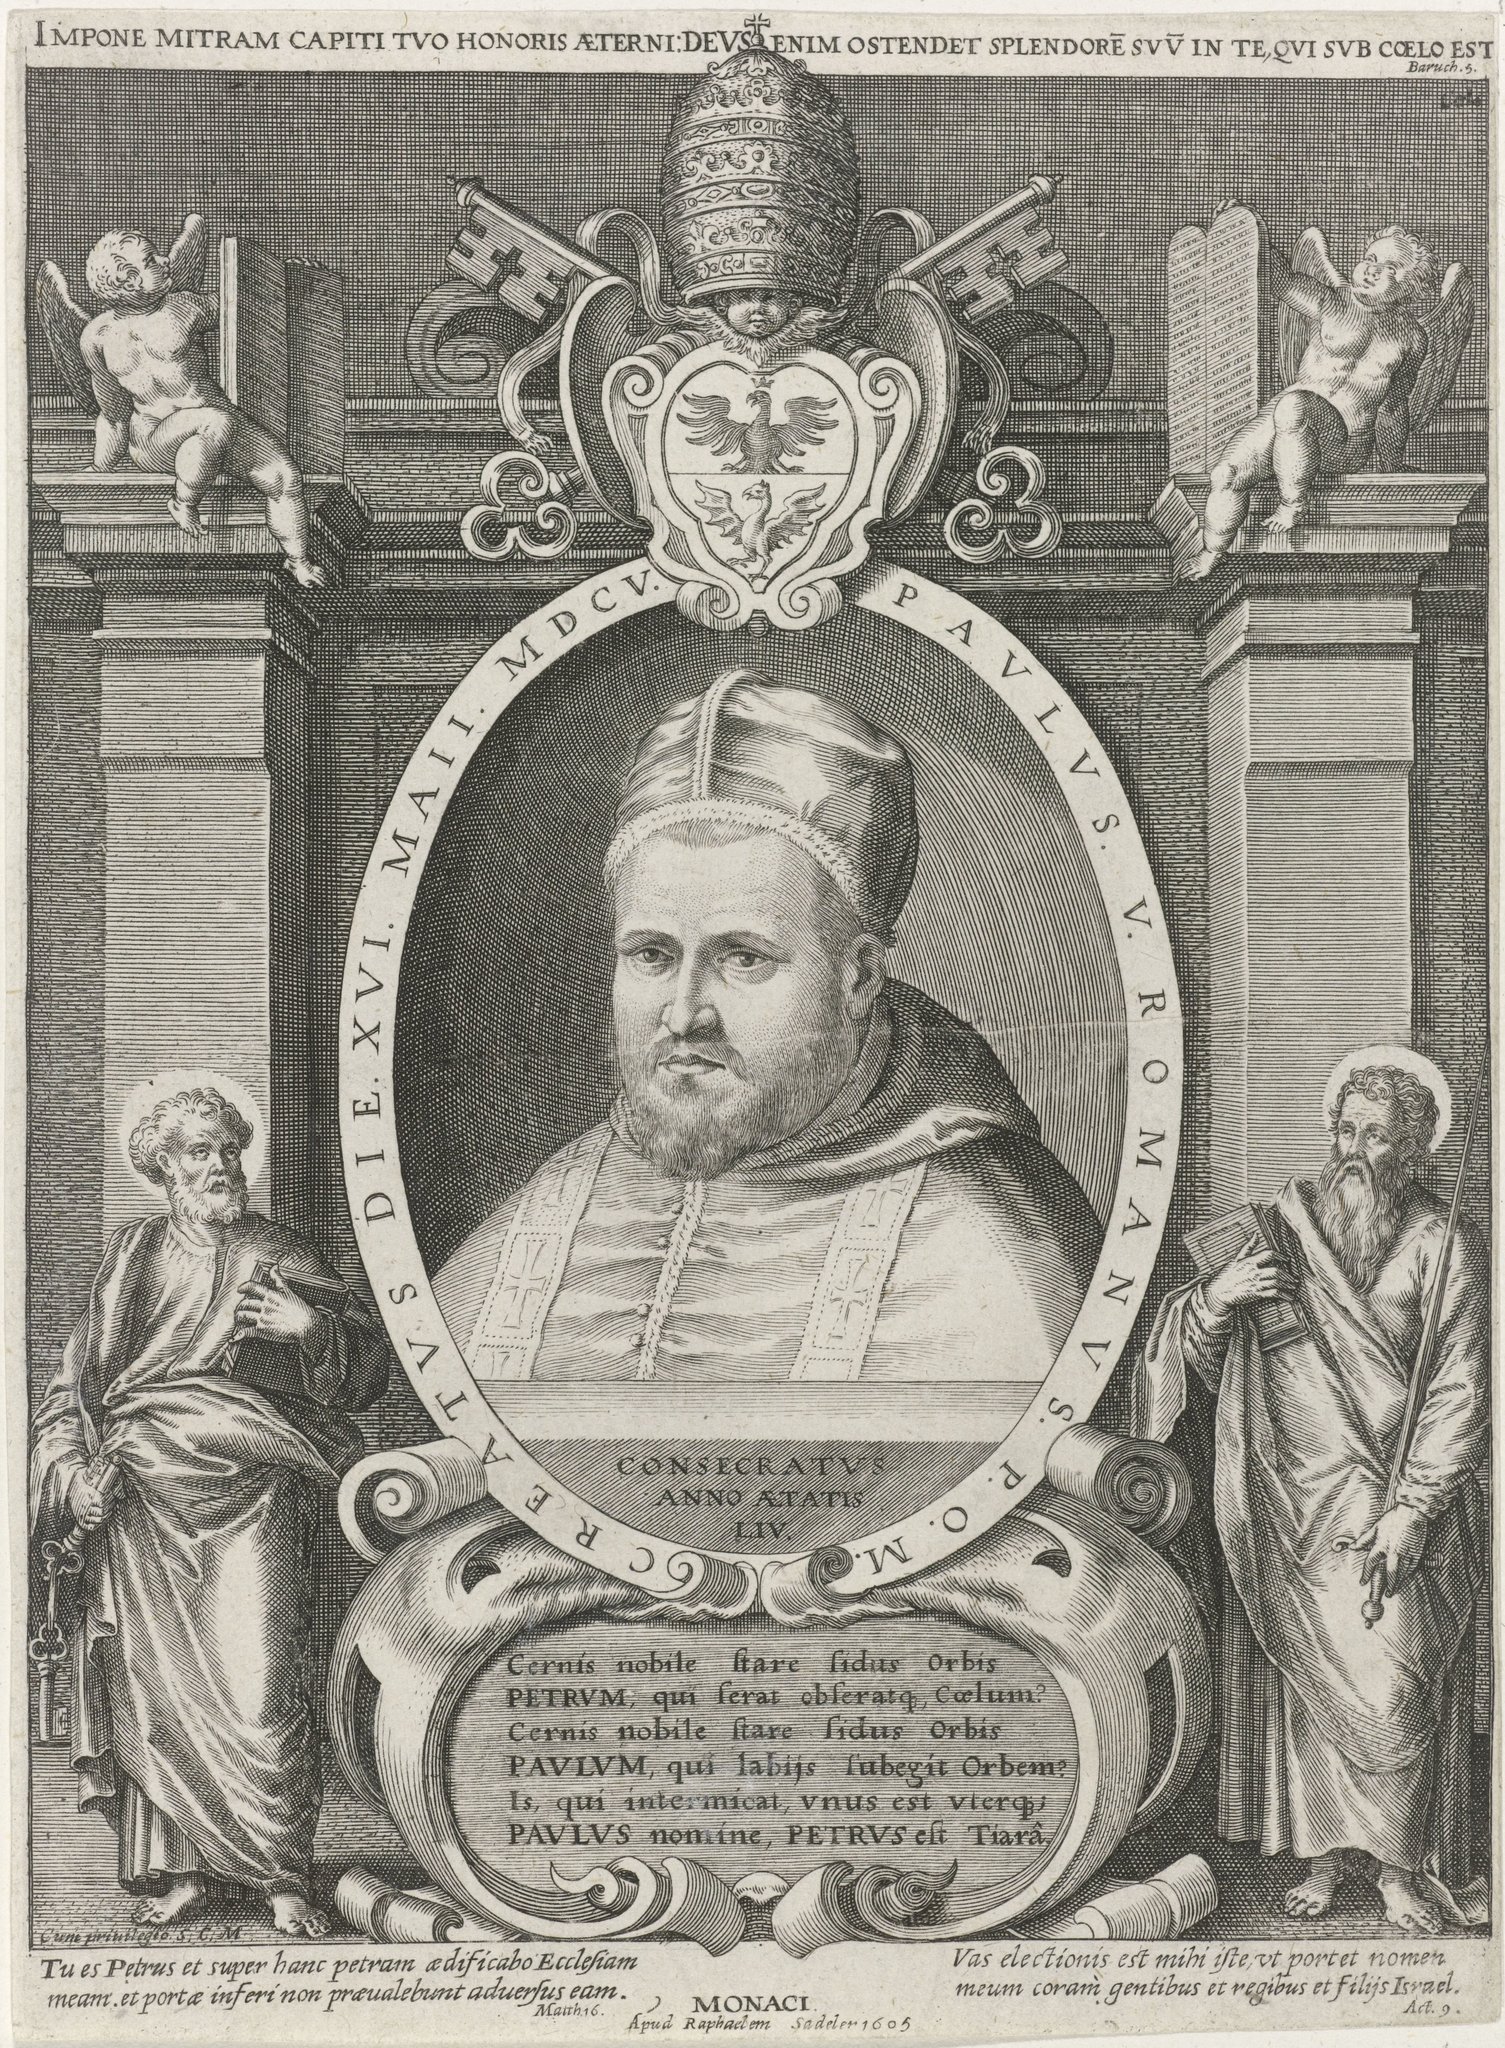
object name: print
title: Portret van Paus Paul V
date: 1605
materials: paper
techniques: engraving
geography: munich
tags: paulus v, insignia of the pope, e.g. tiara, cupids: 'amores', 'amoretti', 'putti', the apostle peter, first bishop of rome; possible attributes: book, cock, (upturned) cross, (triple) crozier, fish, key, scroll, ship, tiara, the apostle paul of tarsus; possible attributes: book, scroll, sword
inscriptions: collector's mark: Lugt 2228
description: Paus Paul V op 54-jarige leeftijd. Boven het portret het pauselijk wapen met aan weerszijden een putto. Het portret wordt geflankeerd door de apostel Petrus (links) en de apostel Paulus (rechts).